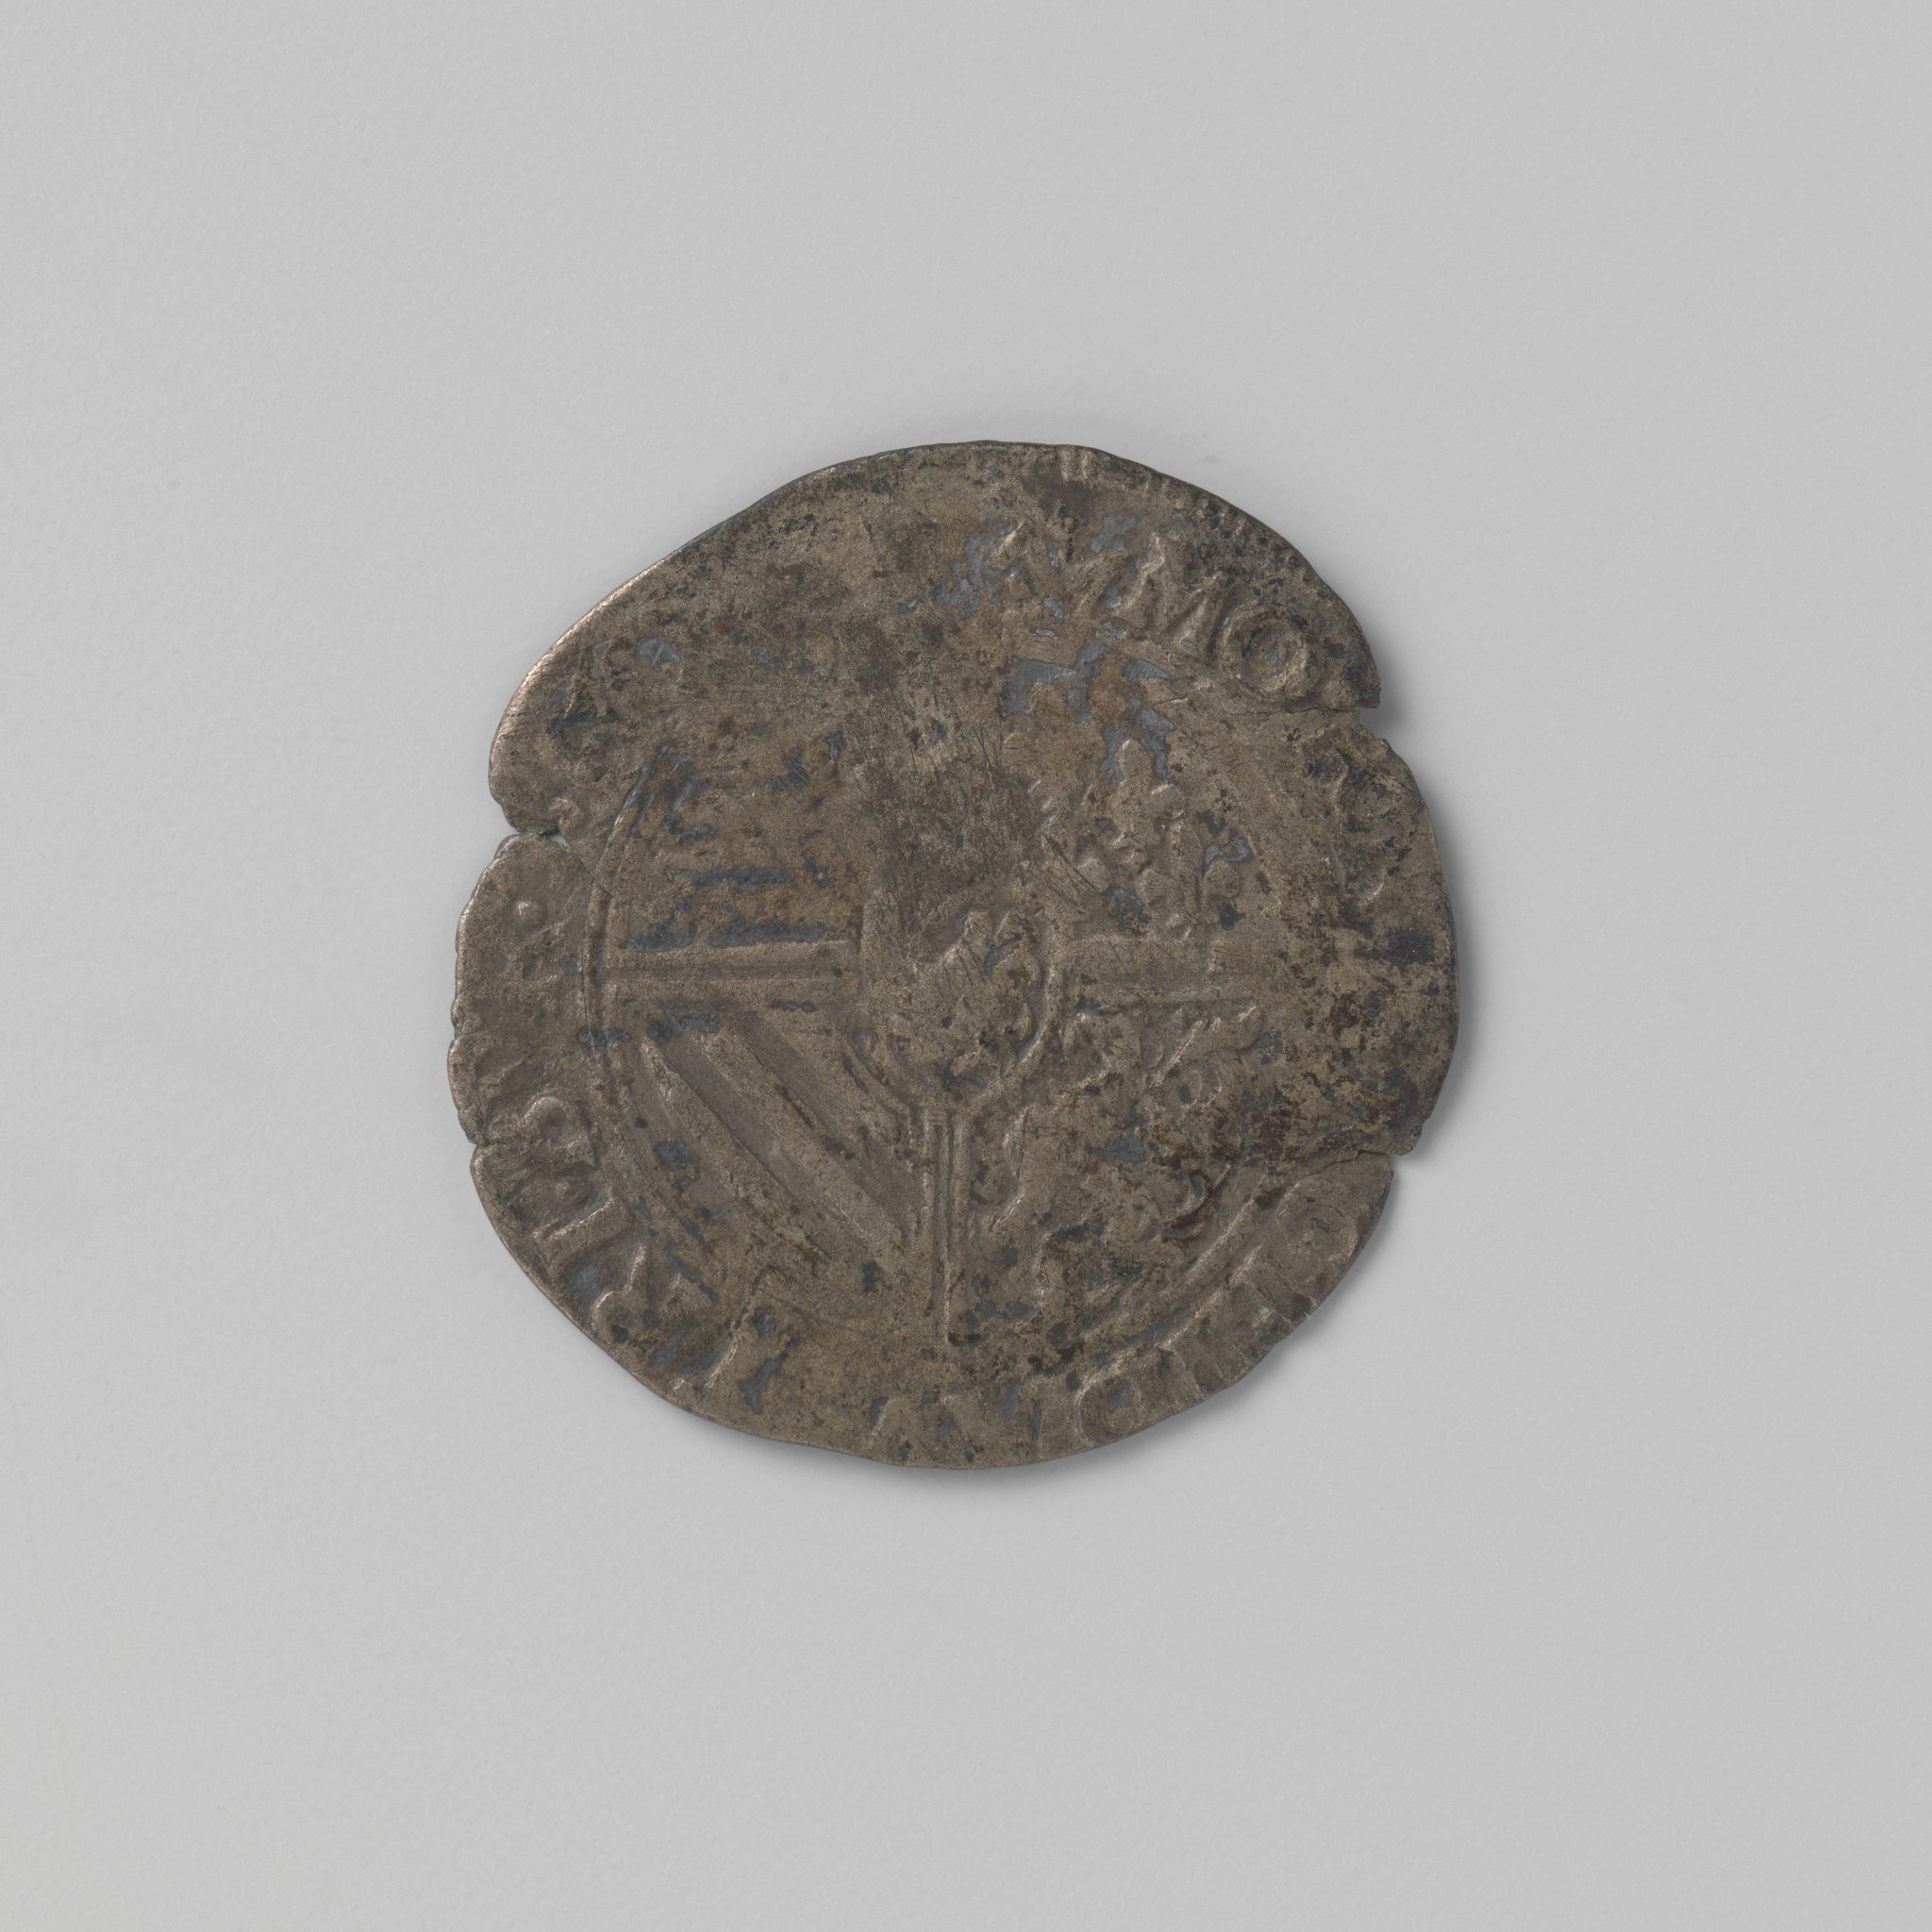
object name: coin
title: Holland, Karel V, groot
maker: charles v (holy roman emperor and king of spain)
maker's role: keizer, koning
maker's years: 1500-1558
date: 1506-1520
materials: silver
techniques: striking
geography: dordrecht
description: Zilveren munt. Voorzijde: onder een kroon wapen van Oostenrijk-Bourgondië in veld. Keerzijde: lang versierd kruis, in hoeken afwisselend leeuwtjes en lelies. Omschrift in Latijnse letters